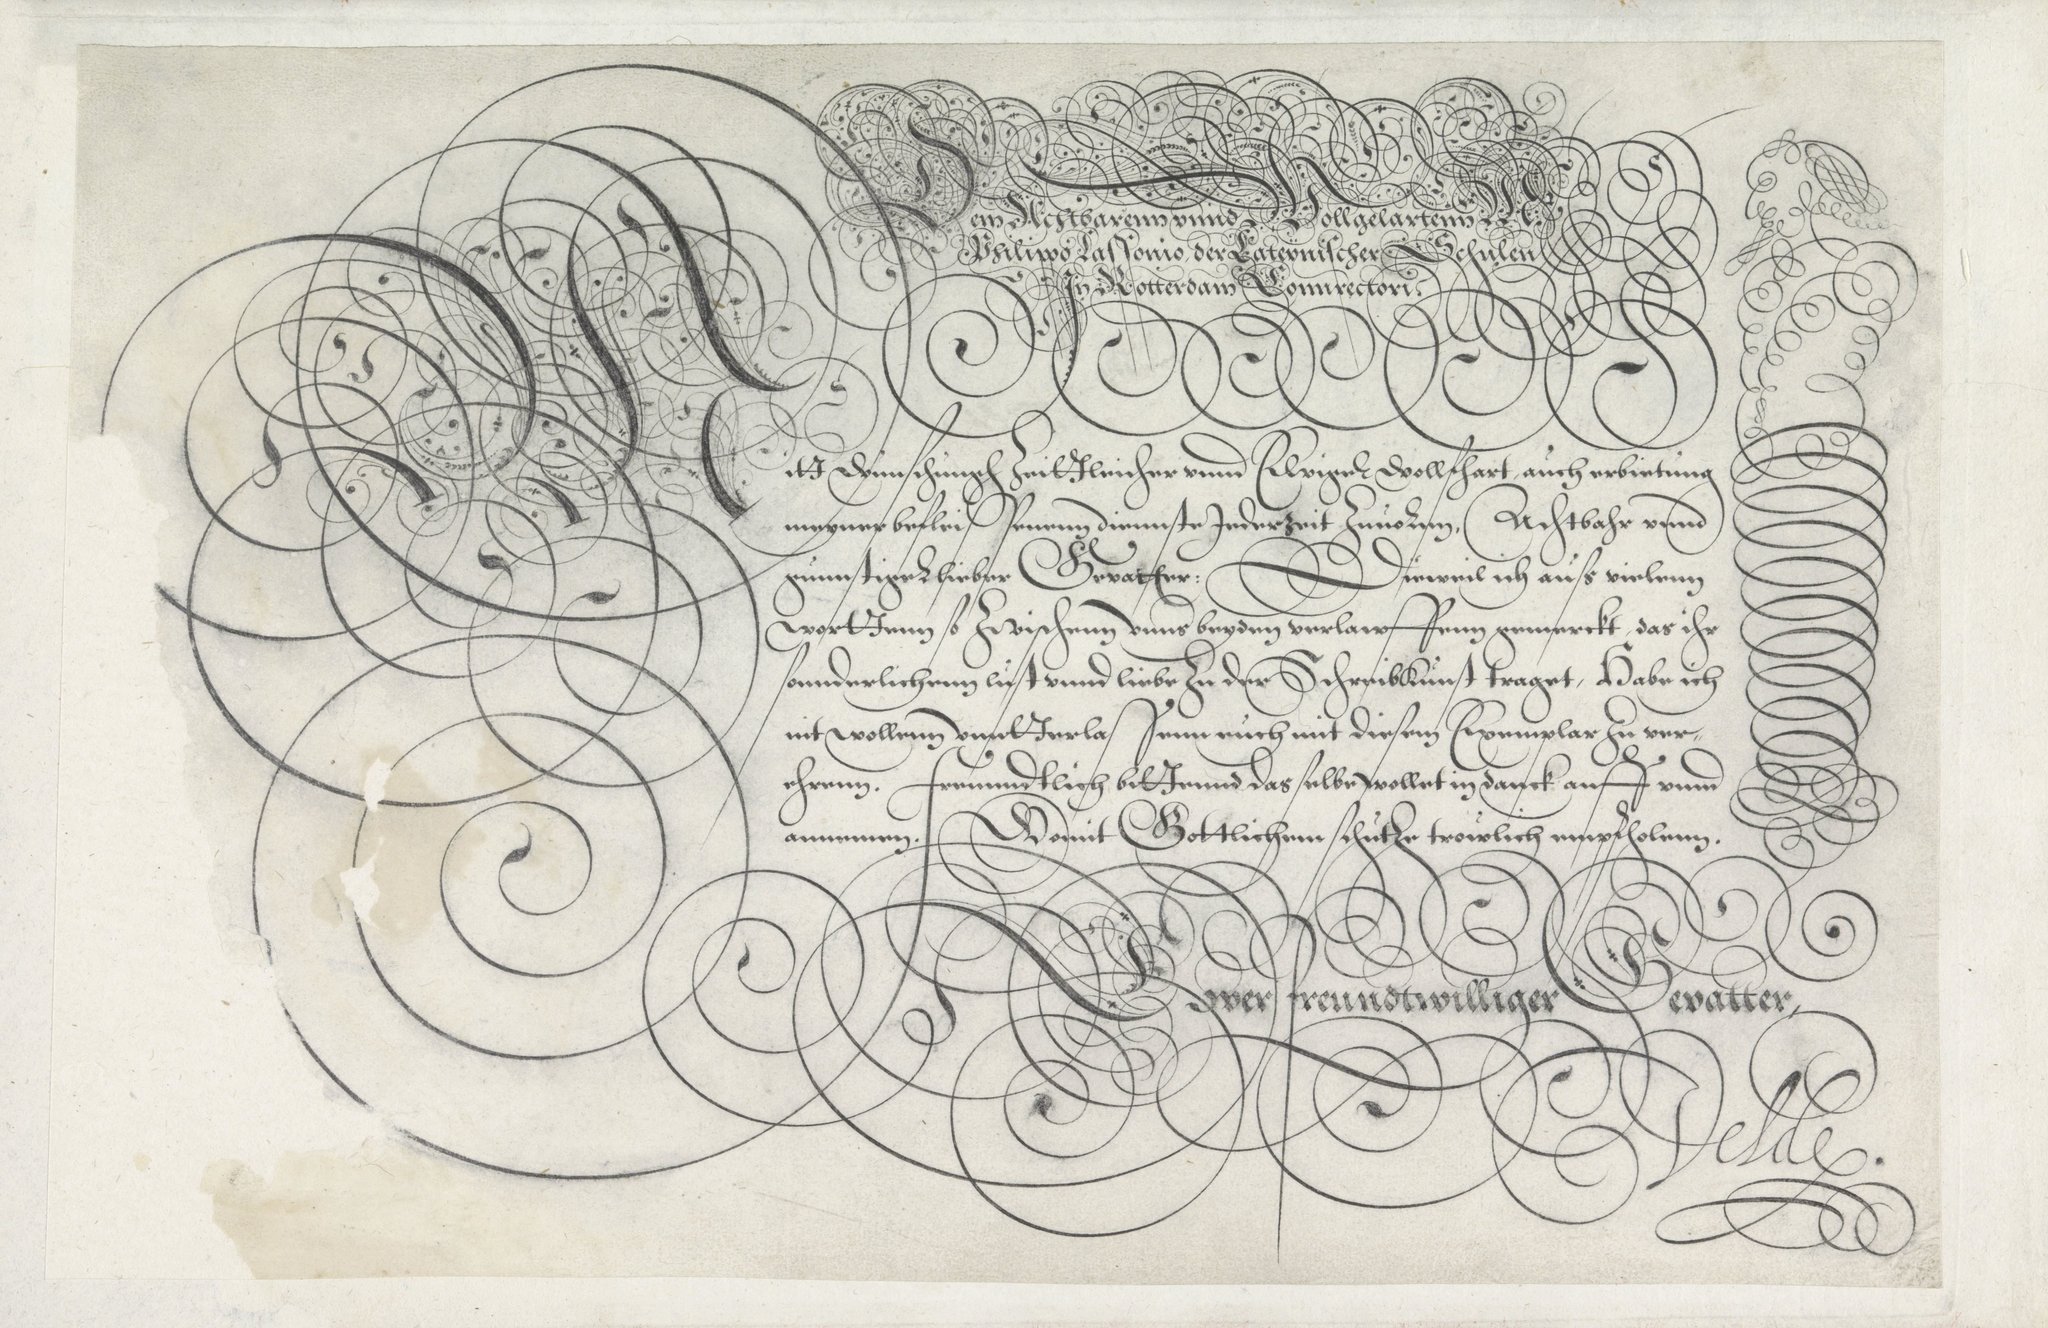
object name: album leaf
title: Ontwerp van een schrijfvoorbeeld: Den achtbarem unnd volgelartem (...)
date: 1605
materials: ink, paper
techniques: calligraphy, pen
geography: rotterdam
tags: calligraphy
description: Kalligrafische tekening met de aanhef: Den achtbarem unnd volgelartem Mr Philippo Lassonio der lateynischer schulen In Rotterdam connrectori. Daaronder een geornamenteerde initiaal M(?) en acht regels tekst in het Duits. Ondertekend: Euuer freundtwilliger gevatter, Velde. De tekst is omlijst door krulwerk. Aan de rechterzijde een herme of grenszuil in krulwerk. De tekening maakt deel uit van een album.